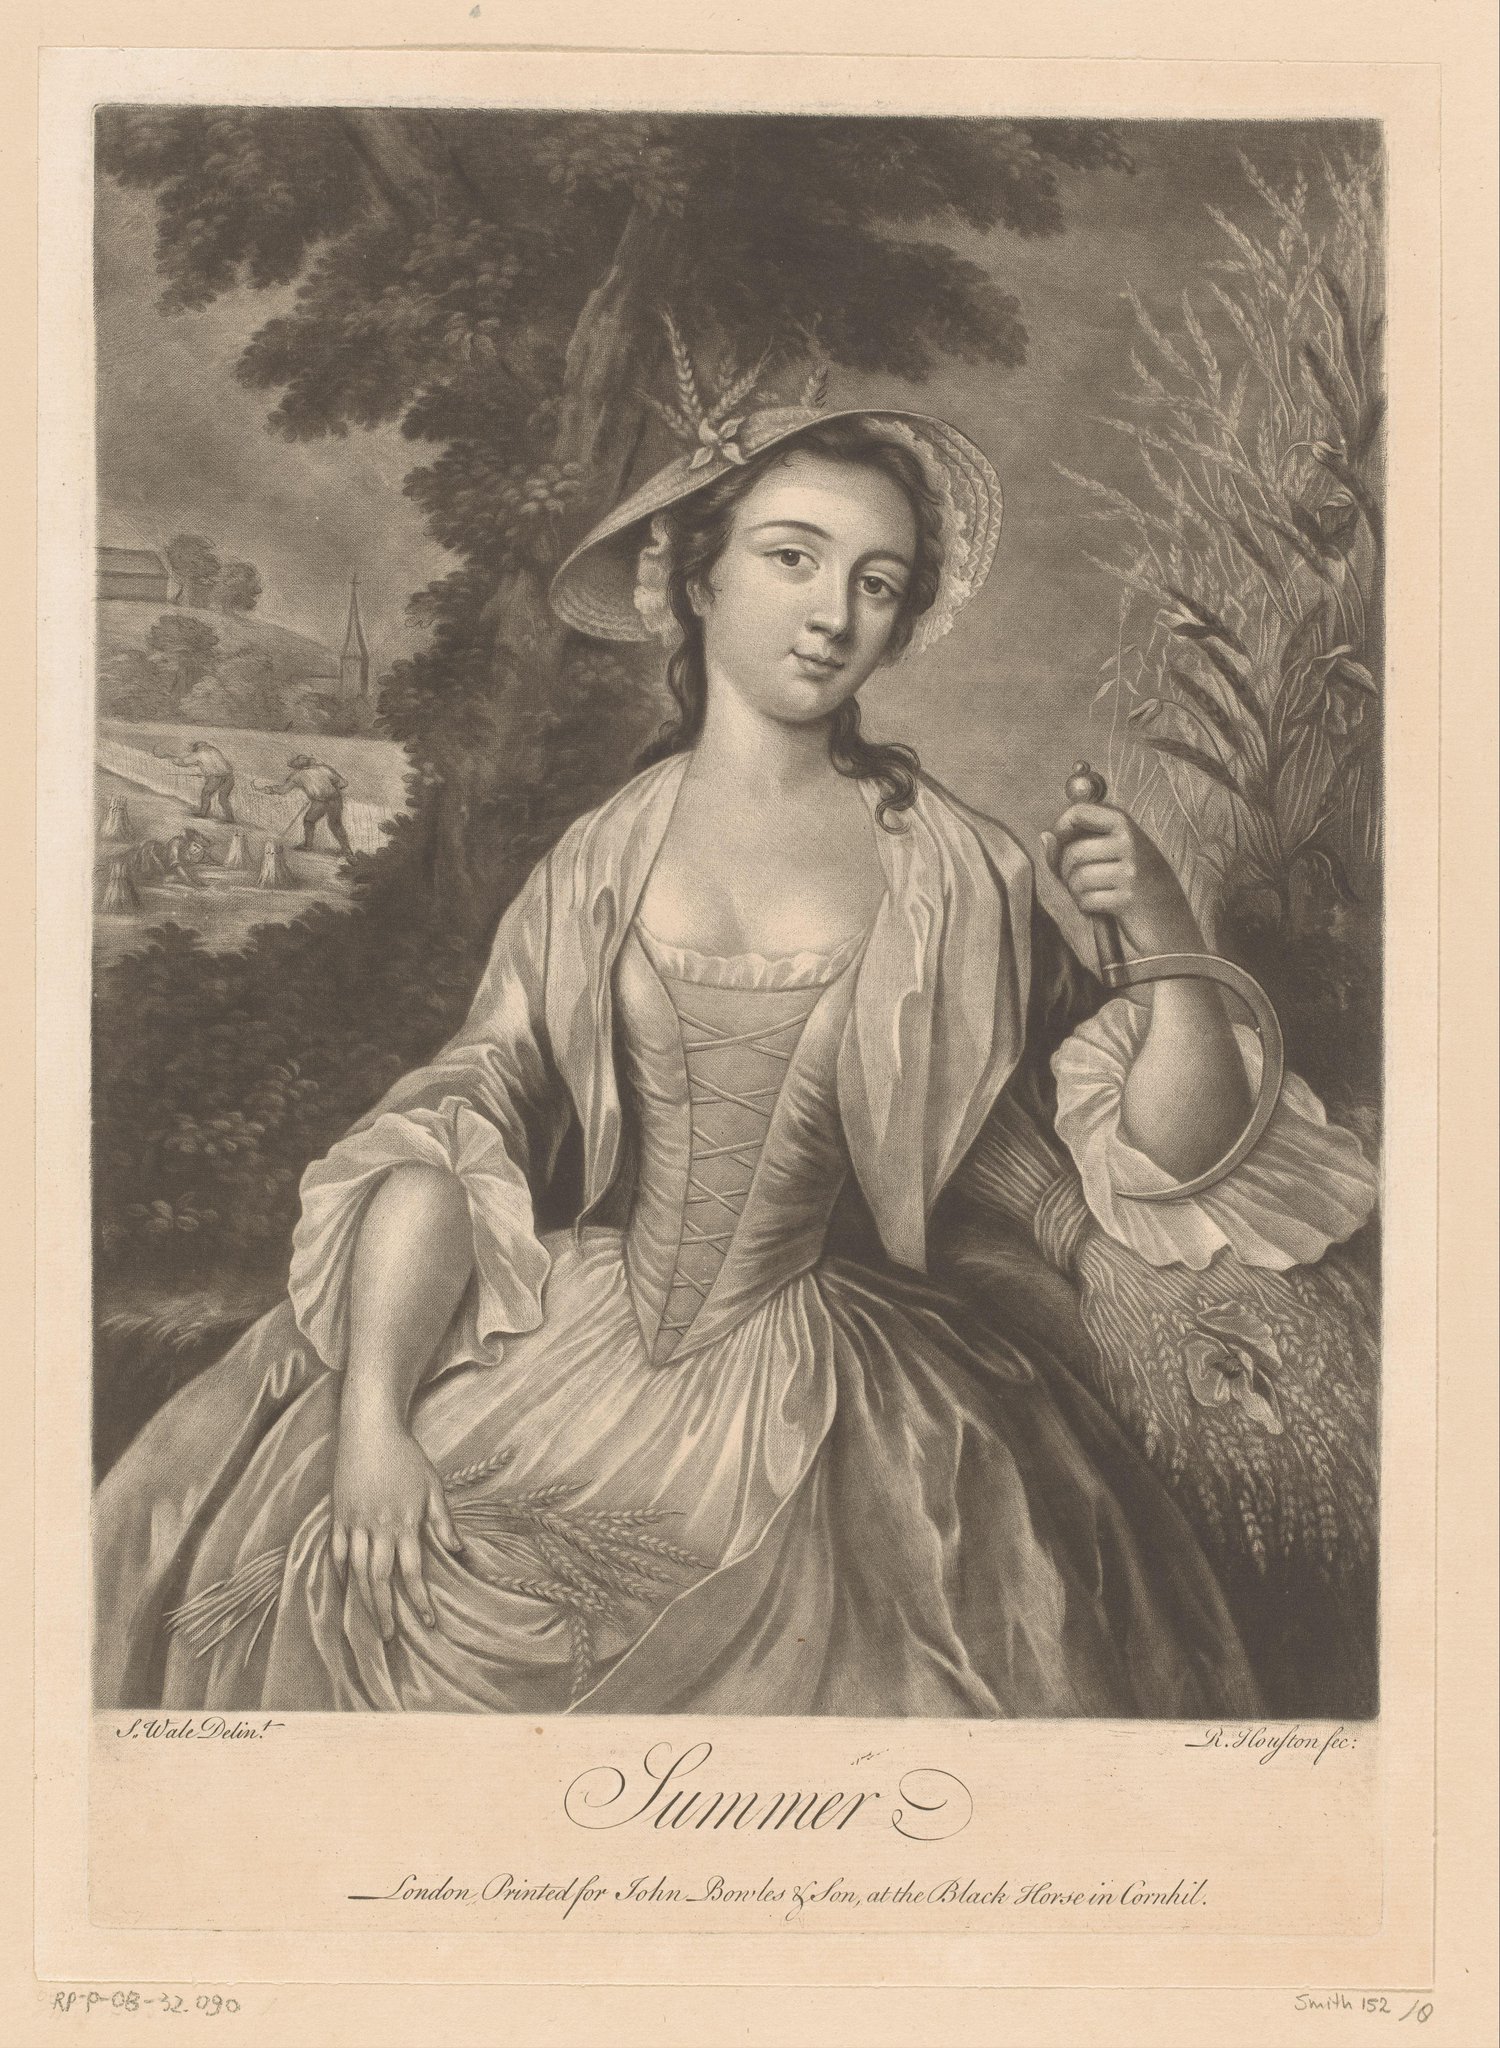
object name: print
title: Summer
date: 1731-1766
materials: paper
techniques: mezzotint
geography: london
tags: adolescent, young woman, maiden, summer, 'aestas'; 'estate' (ripa), summer landscape; landscape symbolizing summer (the four seasons of the year), agricultural implements: sickle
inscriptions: collector's mark: Lugt 240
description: Deze prent maakt deel uit van een serie van vier prenten.